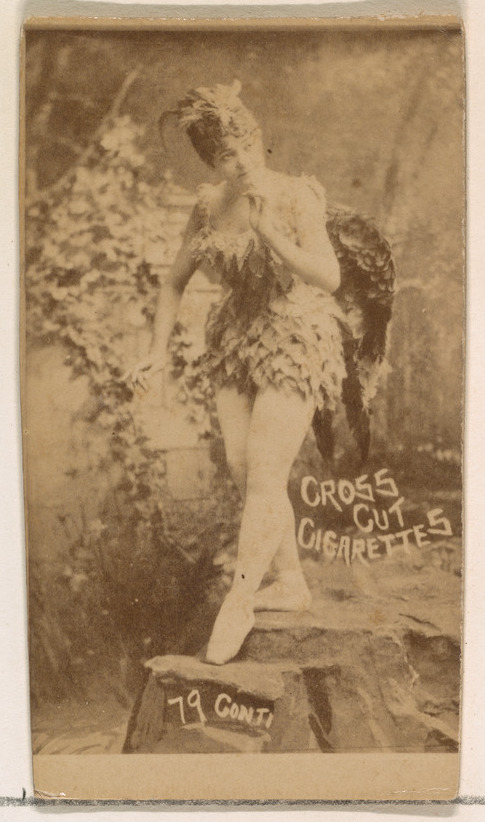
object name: print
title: Card Number 79, Conti, from the Actors and Actresses series (N145-1) issued by Duke Sons & Co. to promote Cross Cut Cigarettes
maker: w. duke, sons & co.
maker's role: publisher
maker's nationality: american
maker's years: 1870-1920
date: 1880-1889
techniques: albumen silver print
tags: portraits,women,actresses